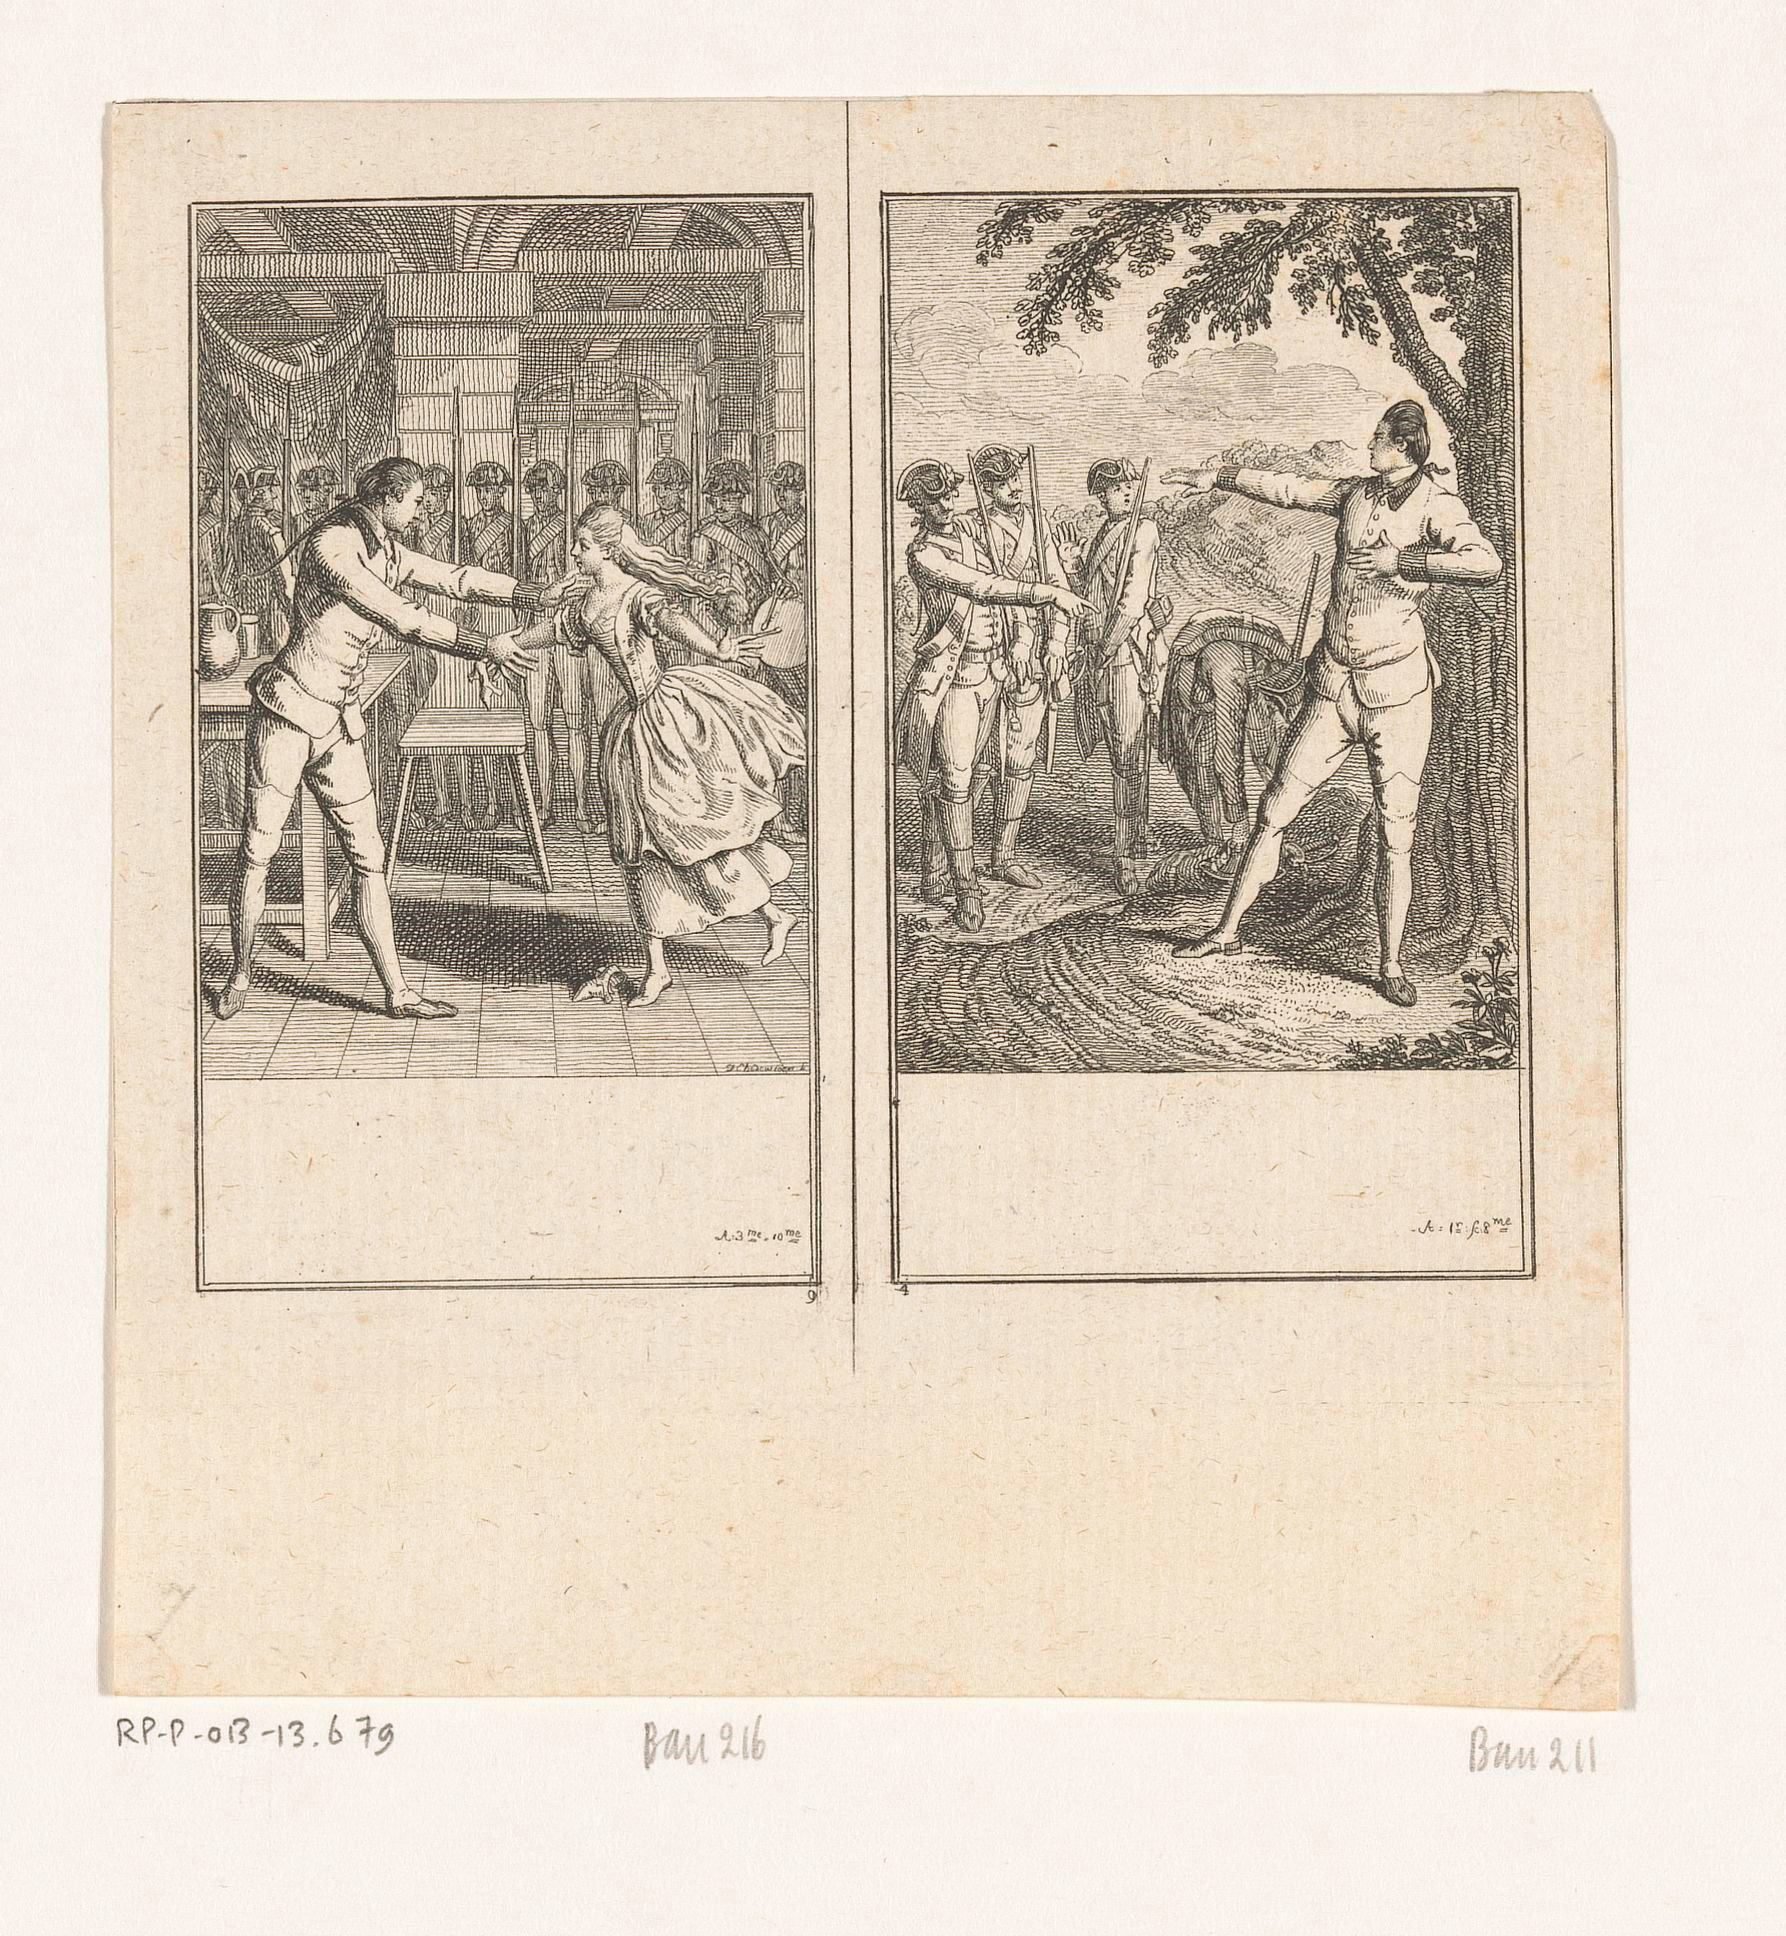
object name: print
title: Twee scènes uit de Deserteur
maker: daniel nikolaus chodowiecki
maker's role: draughtsman, print maker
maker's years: 1726-1801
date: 1774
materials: paper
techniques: etching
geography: berlin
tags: paris, prison, jail, literature, private soldier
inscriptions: collector's mark: Lugt 2228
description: Negende en vierde scène uit een serie van twaalf scènes die de opéra comique 'Le déserteur' door Michel-Jean Sedaine illustreren. De scènes werden op een plaat geëtst. De tweede staat van deze serie werd ook gebruikt in: 'Berliner genealogischen Calender auf das Jahr 1775'.